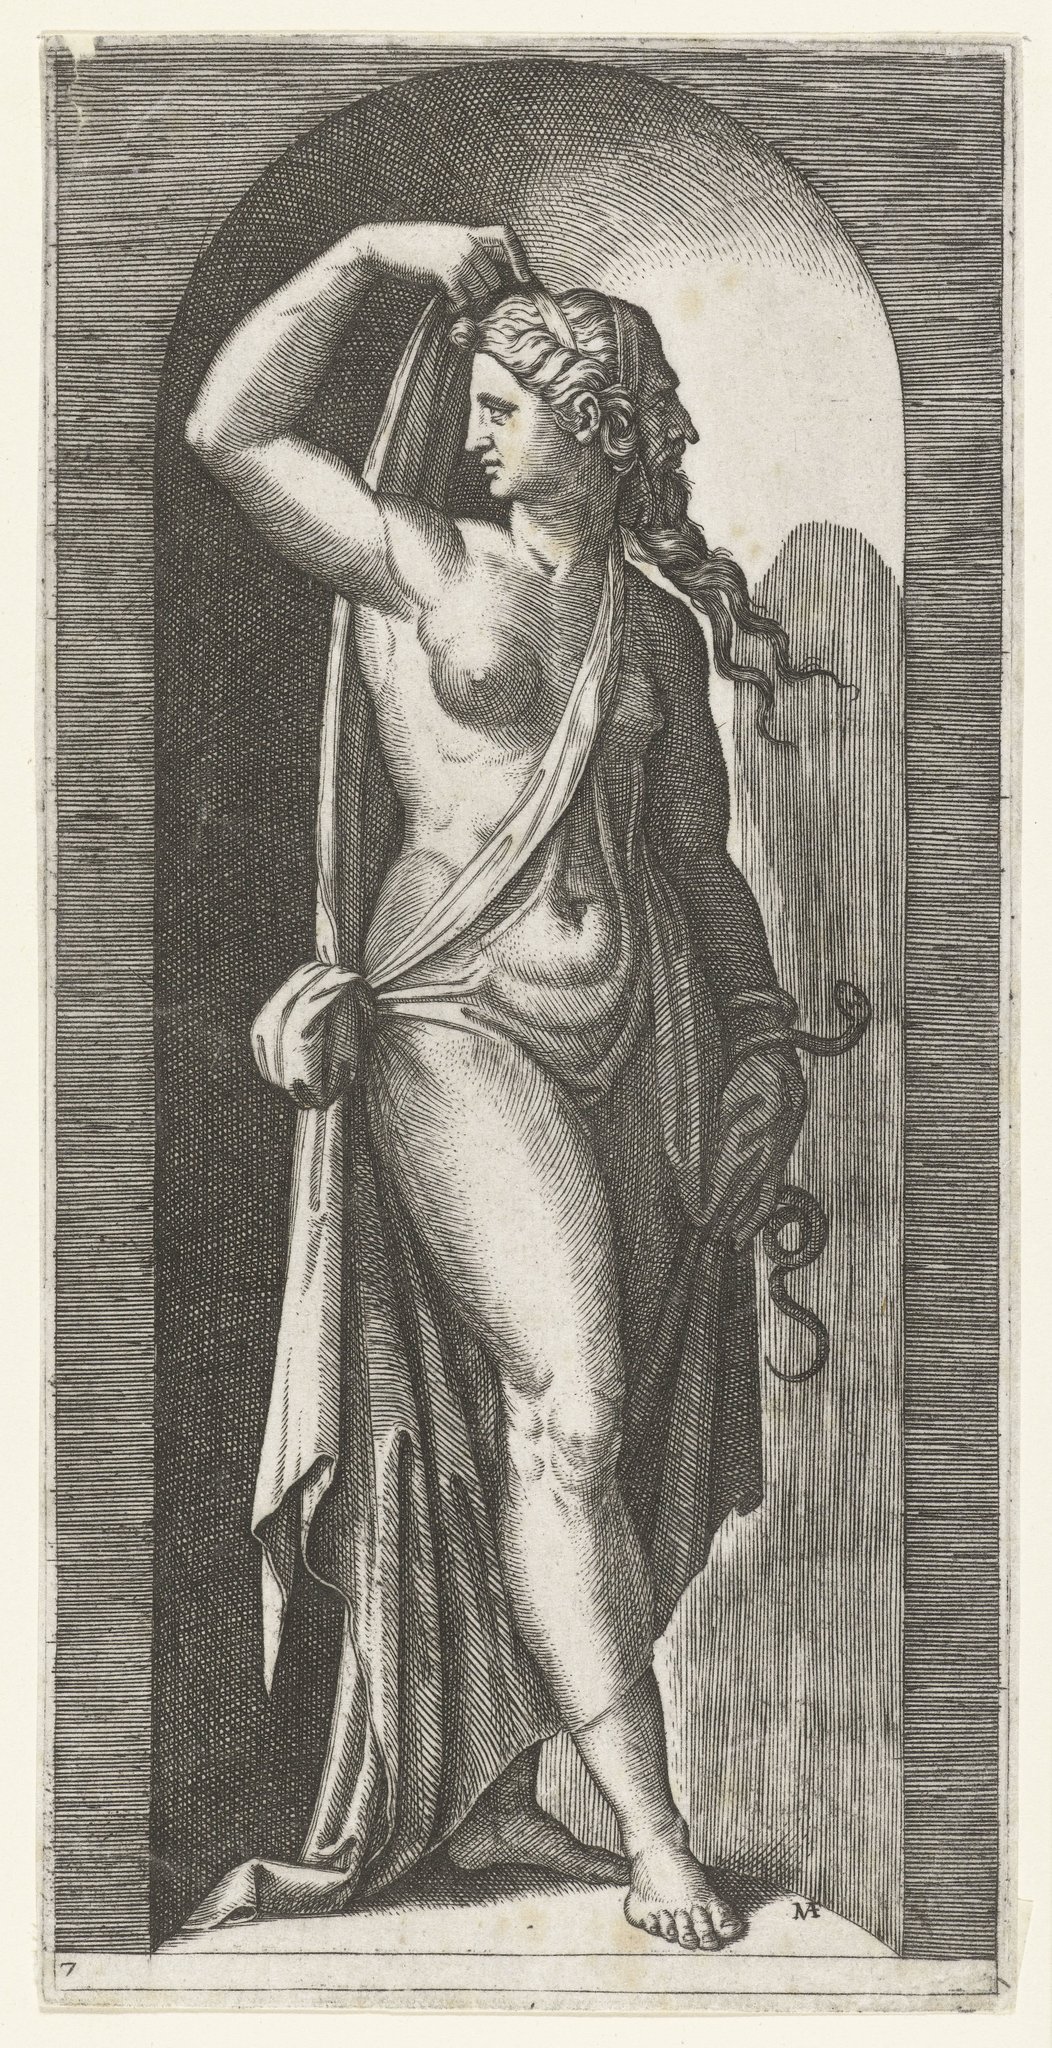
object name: print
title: Zeven Deugden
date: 1510-1527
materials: paper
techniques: engraving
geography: italy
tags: prudence, 'prudentia'; 'prudenza' (ripa) ~ one of the four cardinal virtues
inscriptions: collector's mark: Lugt 240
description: Prent mogelijk naar ontwerp van Raphael. Prent uit een serie van zeven prenten met Deugden.